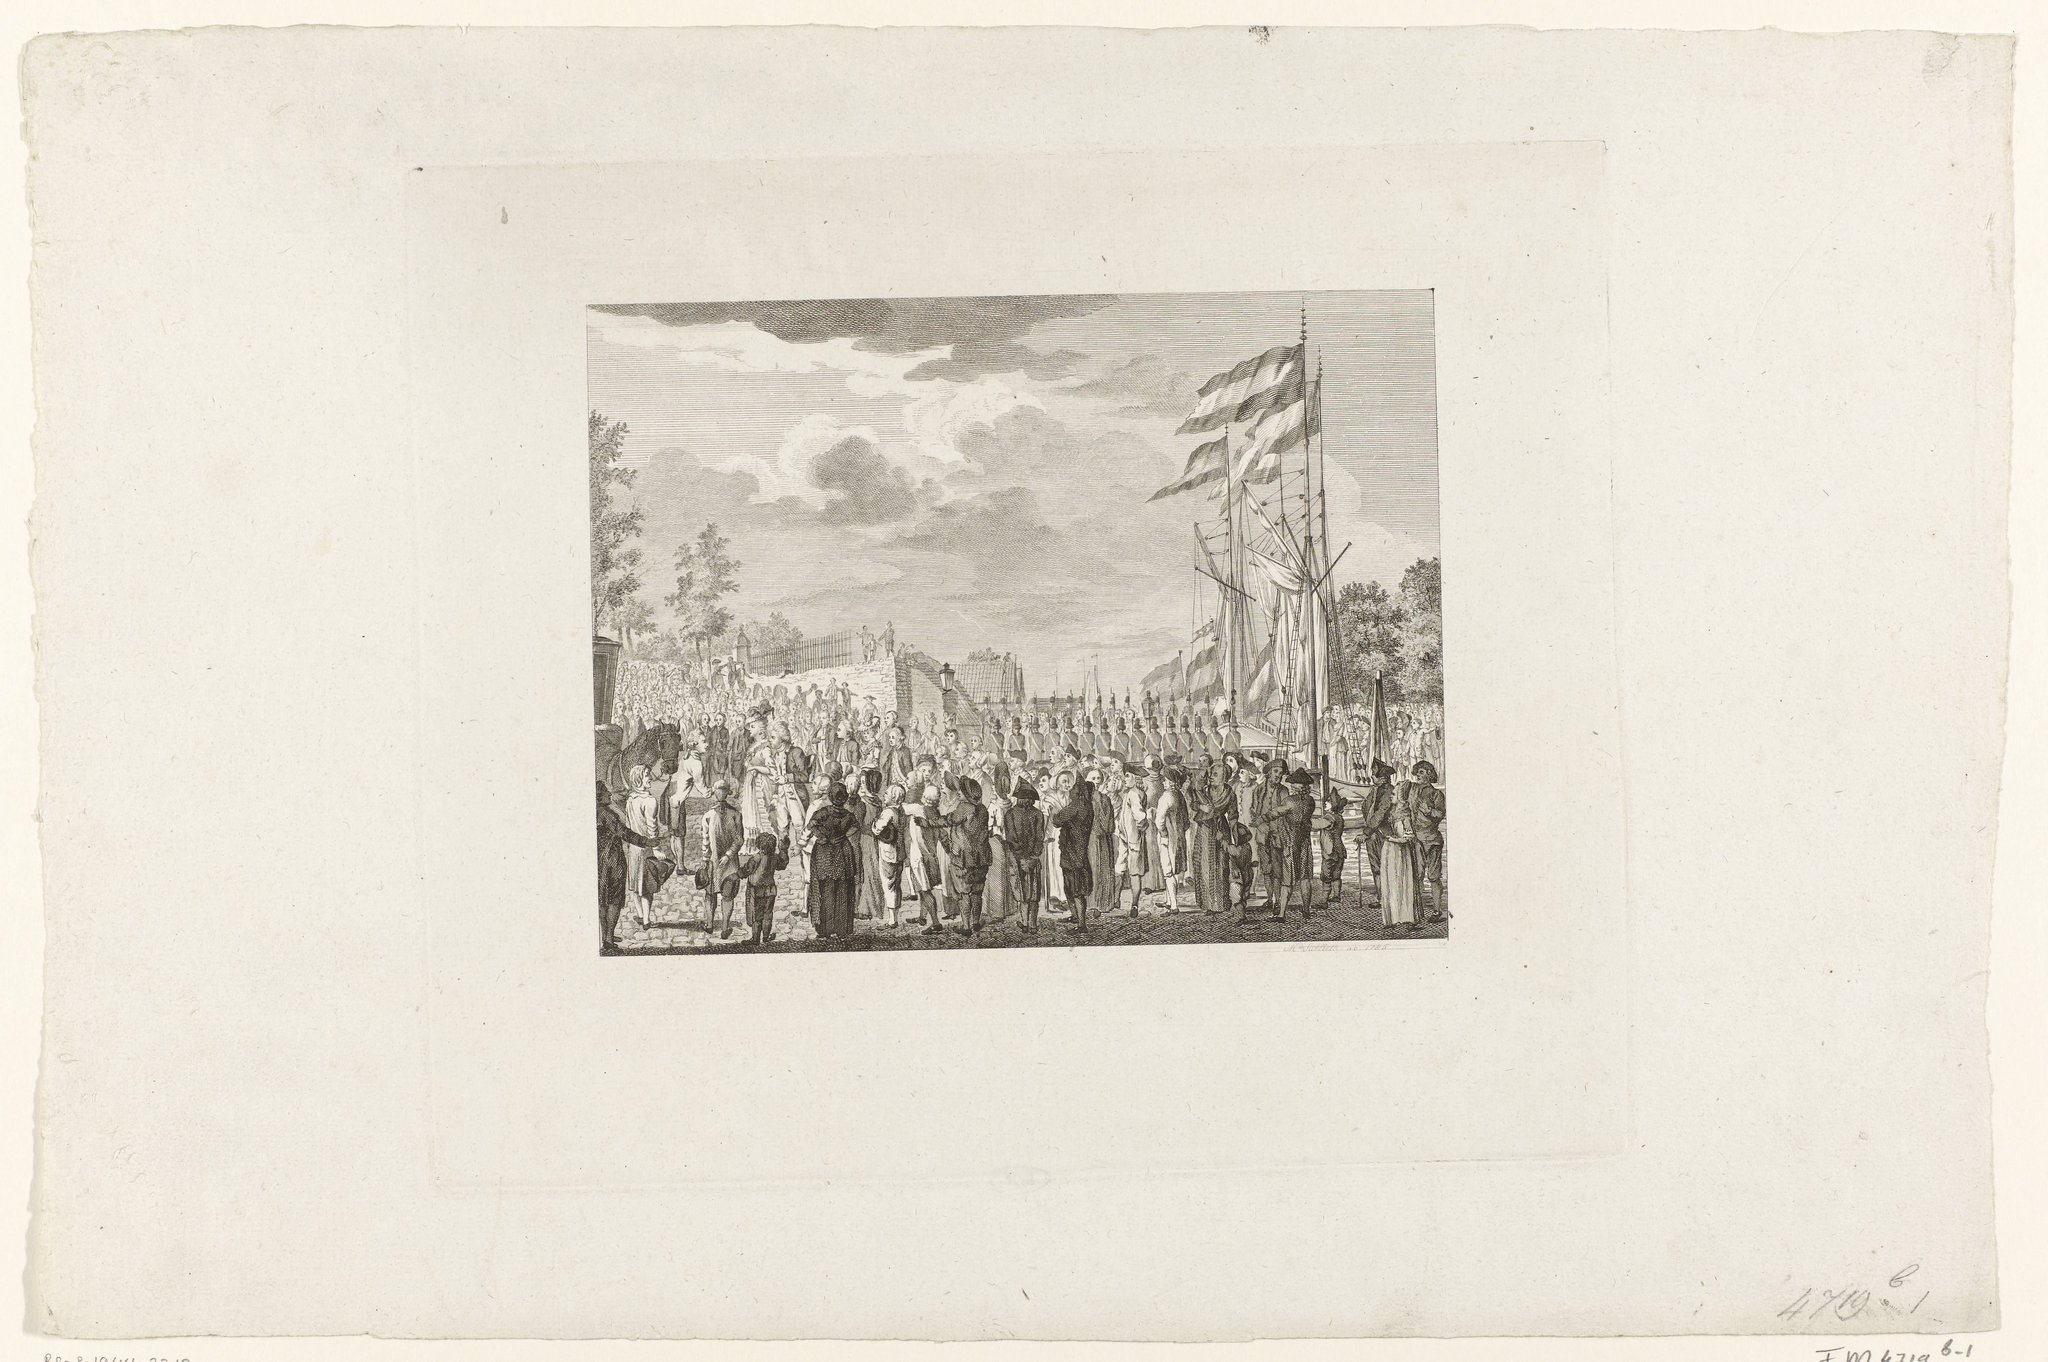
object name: print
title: Aankomst van de prins en prinses van Oranje te Middelburg, 1786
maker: mathias de sallieth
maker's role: print maker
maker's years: 1749-1791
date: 1786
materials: paper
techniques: engraving, etching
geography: middelburg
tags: the hague, william v (prince of orange), berlin, painter, draughtsman, wilhelmina of prussia (princess of orange), public festivities on the occasion of royal events, being welcomed ~ travelling, middelburg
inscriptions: collector's mark: Lugt 2228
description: Aankomst van prins Willem V en prinses Wilhelmina van Pruisen en hun kinderen te Middelburg op 18 juni 1786. Illustraties van het bezoek van de prins en prinses aan Zeeland 18 juni - 25 juli 1786.